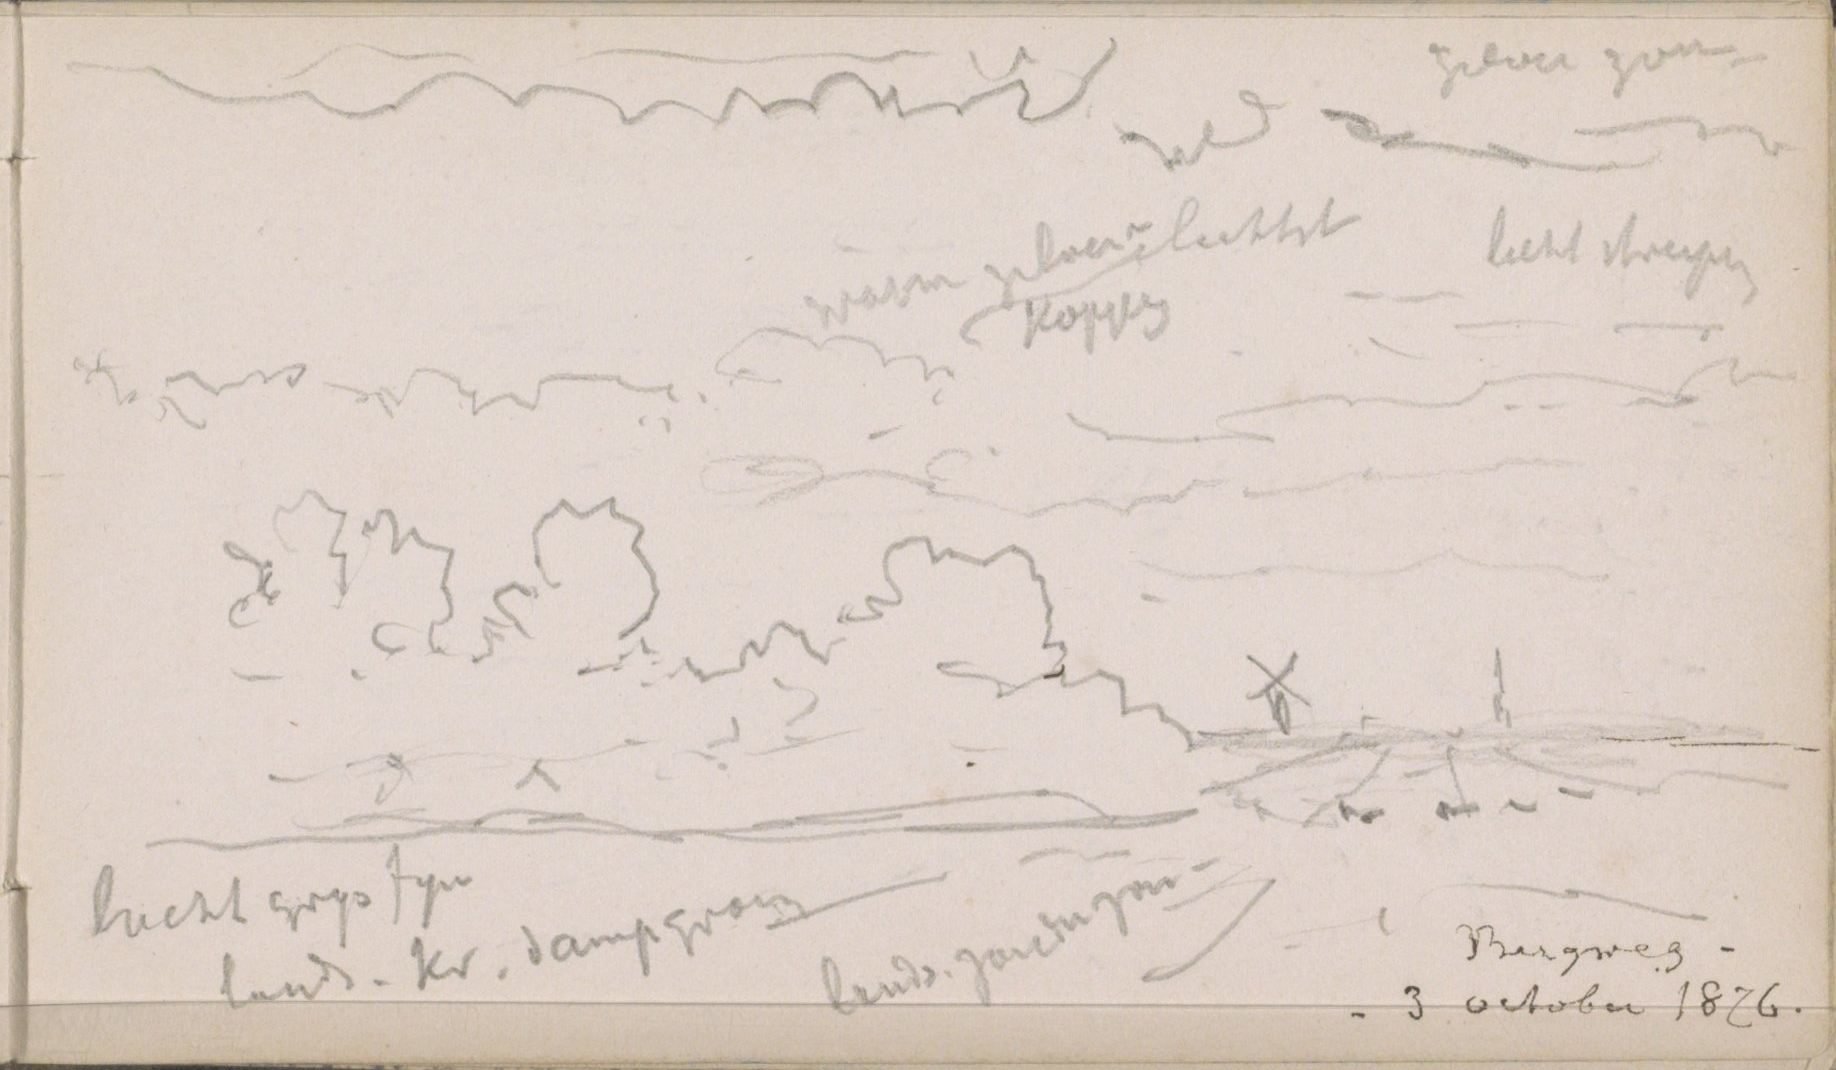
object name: sketchbook leaf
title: Landschap met bomen en struiken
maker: johannes tavenraat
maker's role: draughtsman, painter, print maker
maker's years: 1809-1881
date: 1809-1876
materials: paper, pencil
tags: trees, landscapes, shrubs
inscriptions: date: ‘18/9 76’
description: Blad 41 recto uit een schetsboek met 46 bladen.